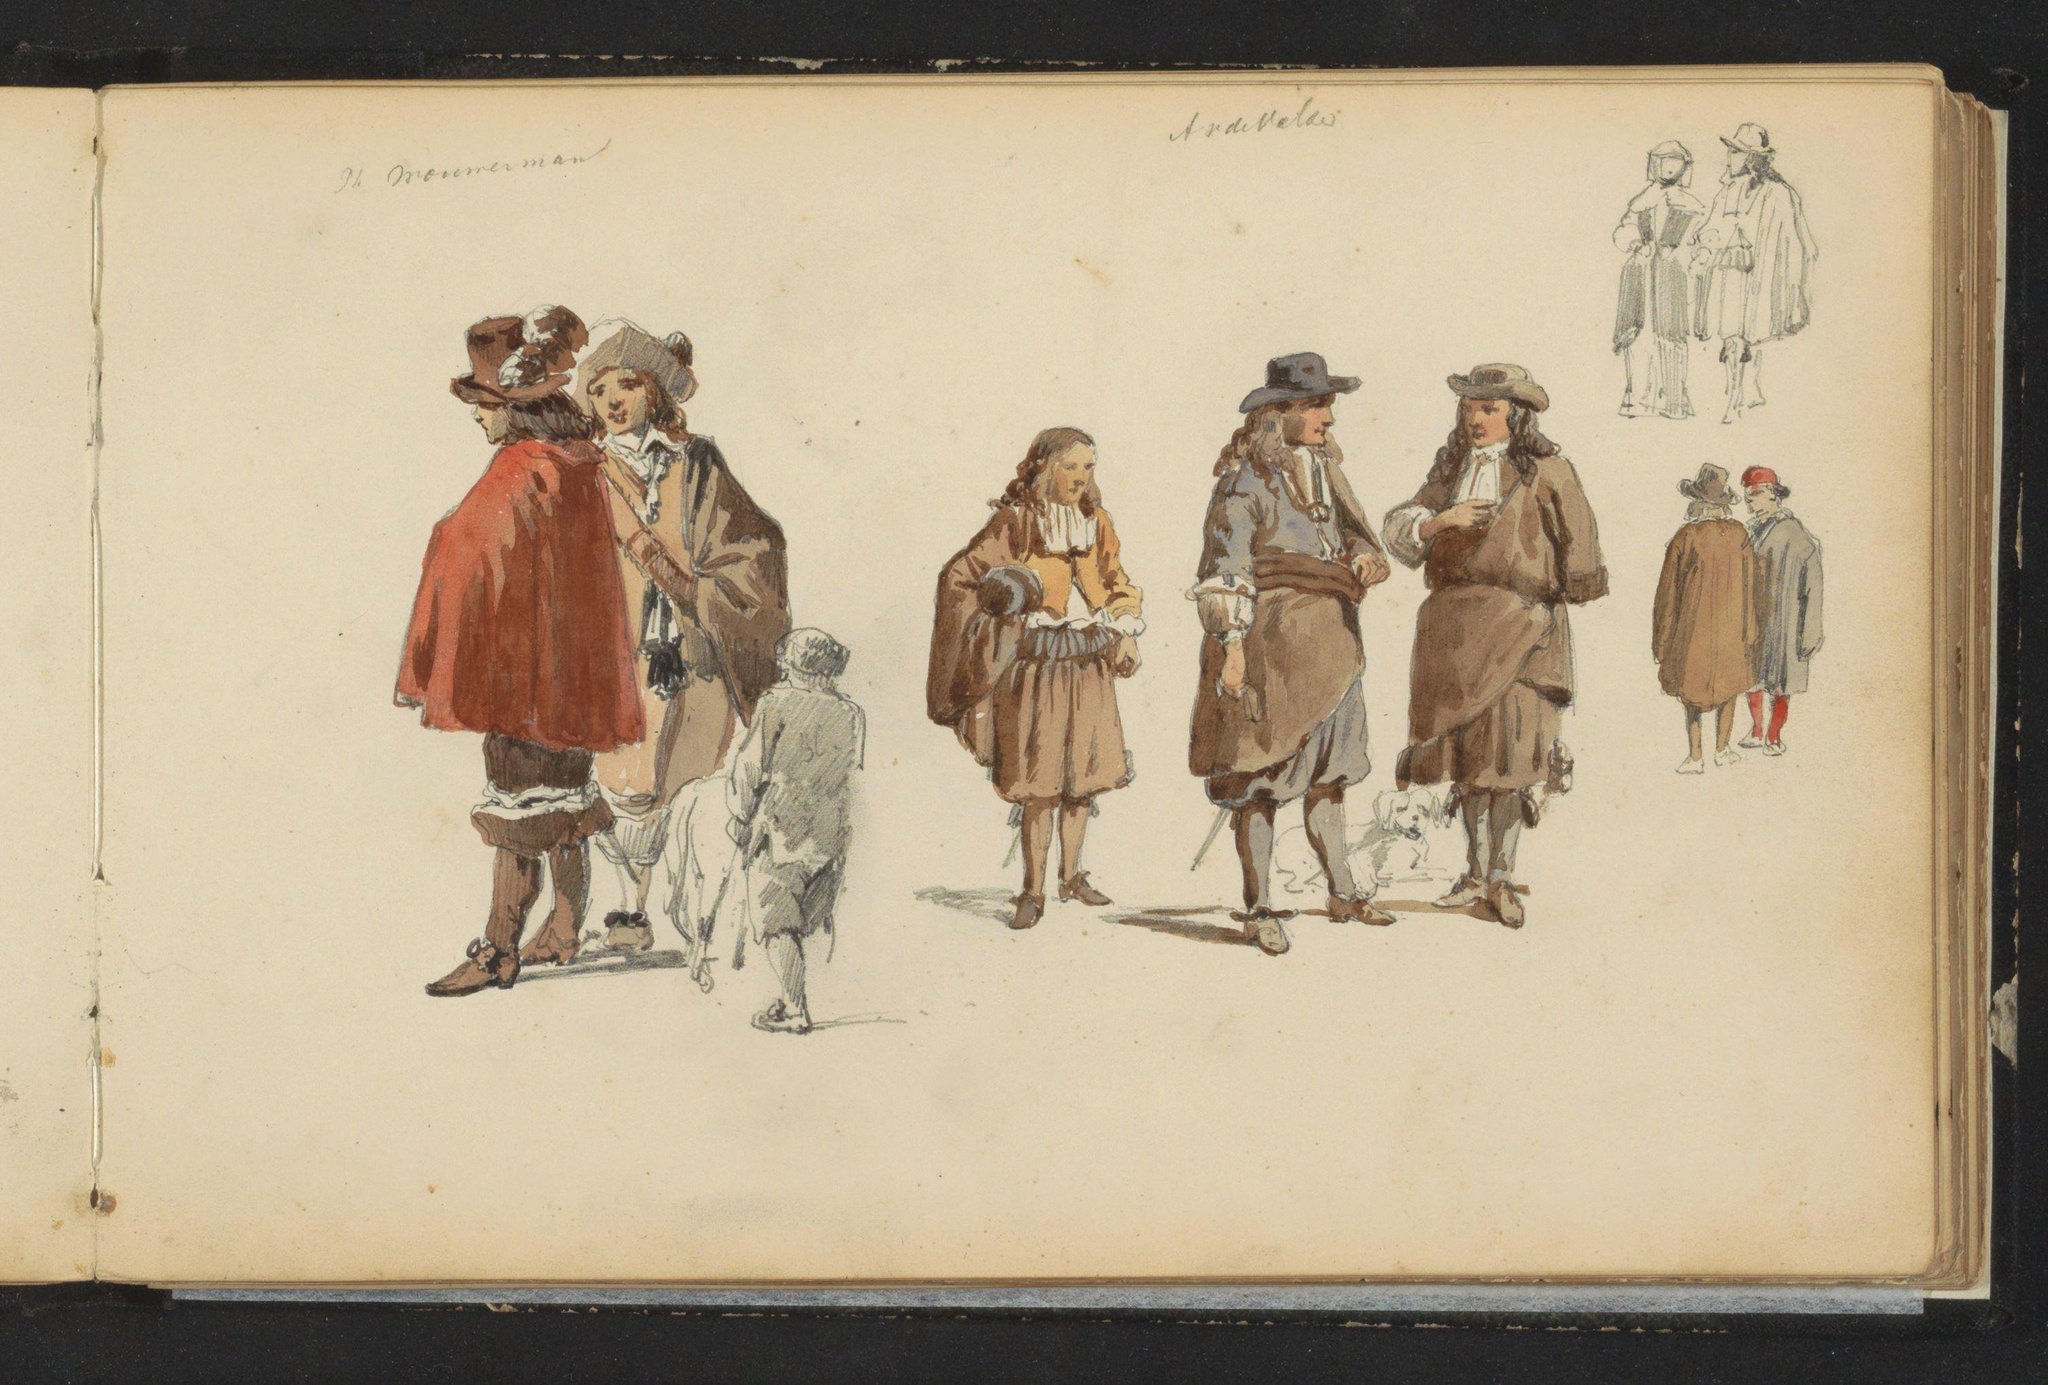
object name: sketchbook leaf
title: Figuren in zeventiende-eeuwse kleding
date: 1846-1882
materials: paper, pencil, watercolor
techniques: stumping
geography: netherlands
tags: clothes, costume (+ children's clothes), adult woman, adult man, clothes, costume (+ women's clothes), clothes, costume (+ men's clothes), dog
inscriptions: annotation: ‘Ph. Wouwerman/ A. v. de Velde’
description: Links een jongen en een hond bij twee mannen. Rechts verschillende groepen figuren. Allen in zeventiende-eeuwse kleding. Blad 27 uit een schetsboek met 91 bladen.